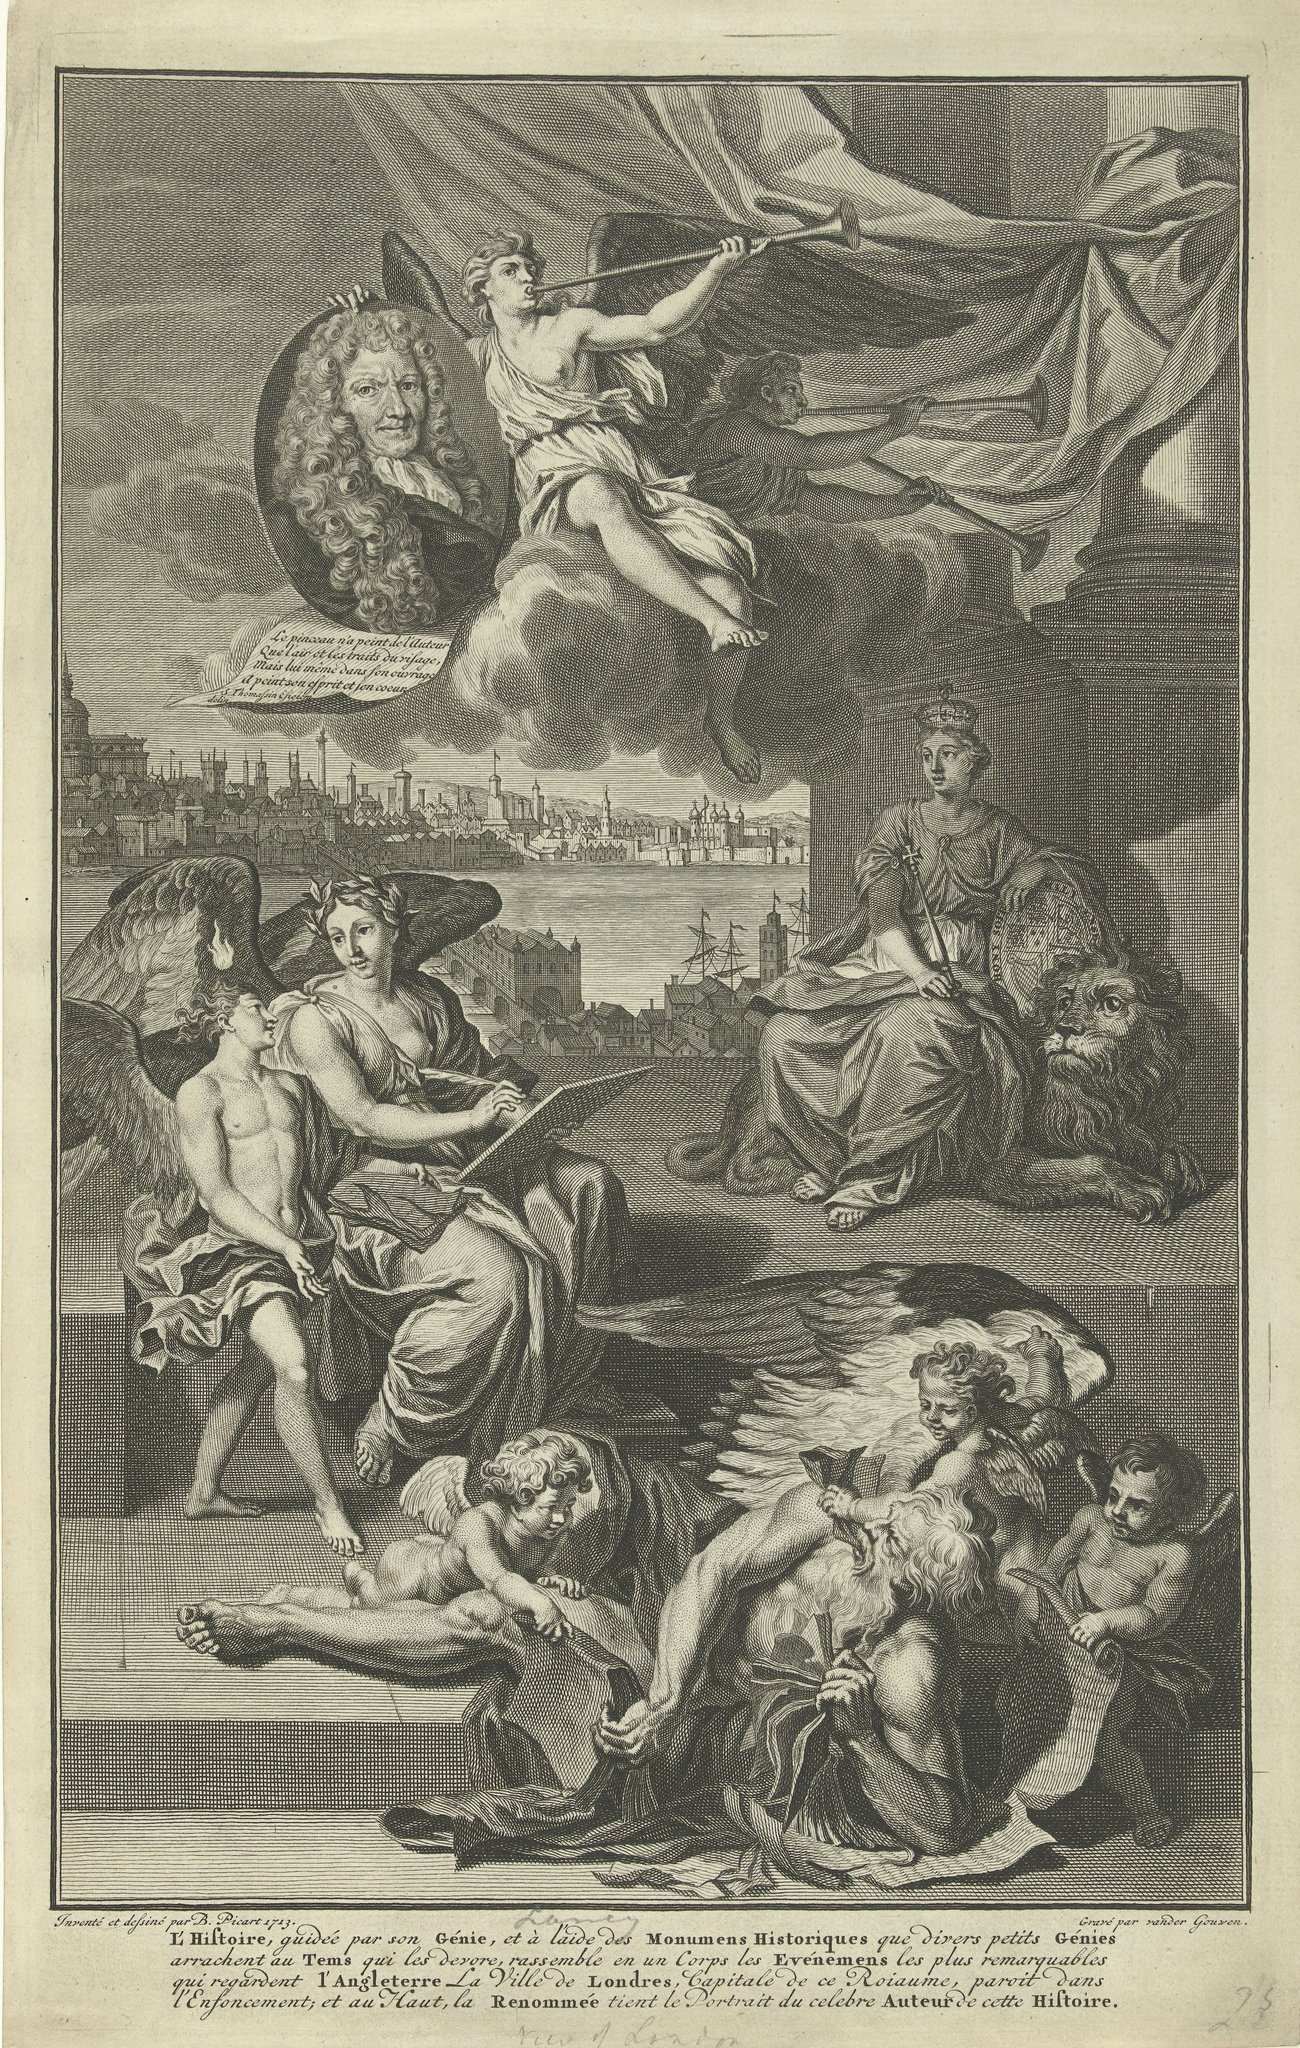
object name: titelprent, frontispice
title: Allegorie op de geschiedenis van Groot-Brittannië met het portret van Isaac de Larrey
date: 1713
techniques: engraving, etching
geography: amsterdam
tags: berlin, coat of arms (as symbol of the state, etc.), personifications of countries, nations, states, districts, etc., beasts of prey, predatory animals: lion (+ animals used symbolically), inspiration; 'ispiratione' (ripa), 'historia'; 'historia' (ripa), fame; 'fama', 'fama buona', 'fama chiara' (ripa), cupids: 'amores', 'amoretti', 'putti', father time, man with wings and scythe, london, england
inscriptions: collector's mark: Lugt 2228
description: De personificatie geschiedenis, gezeten op de vloer, schrijft samen met de personificatie Inspiratie de geschiedenis van Groot-Brittannië. Rechts bij een zuil de personificatie van Groot-Brittannië, zittend op een leeuw. In haar handen het wapenschild van Groot-Brittannië. Op de voorgrond trachten drie putti de gevleugelde Tijd tegen te houden, die boeken verscheurt en opeet. Boven de personificatie Faam, blazend op een portret. Ze draagt het portret in ovale lijst van de Franse historicus Isaac de Larrey. Op de achtergrond de stad Londen. De prent heeft een Frans onderschrift.